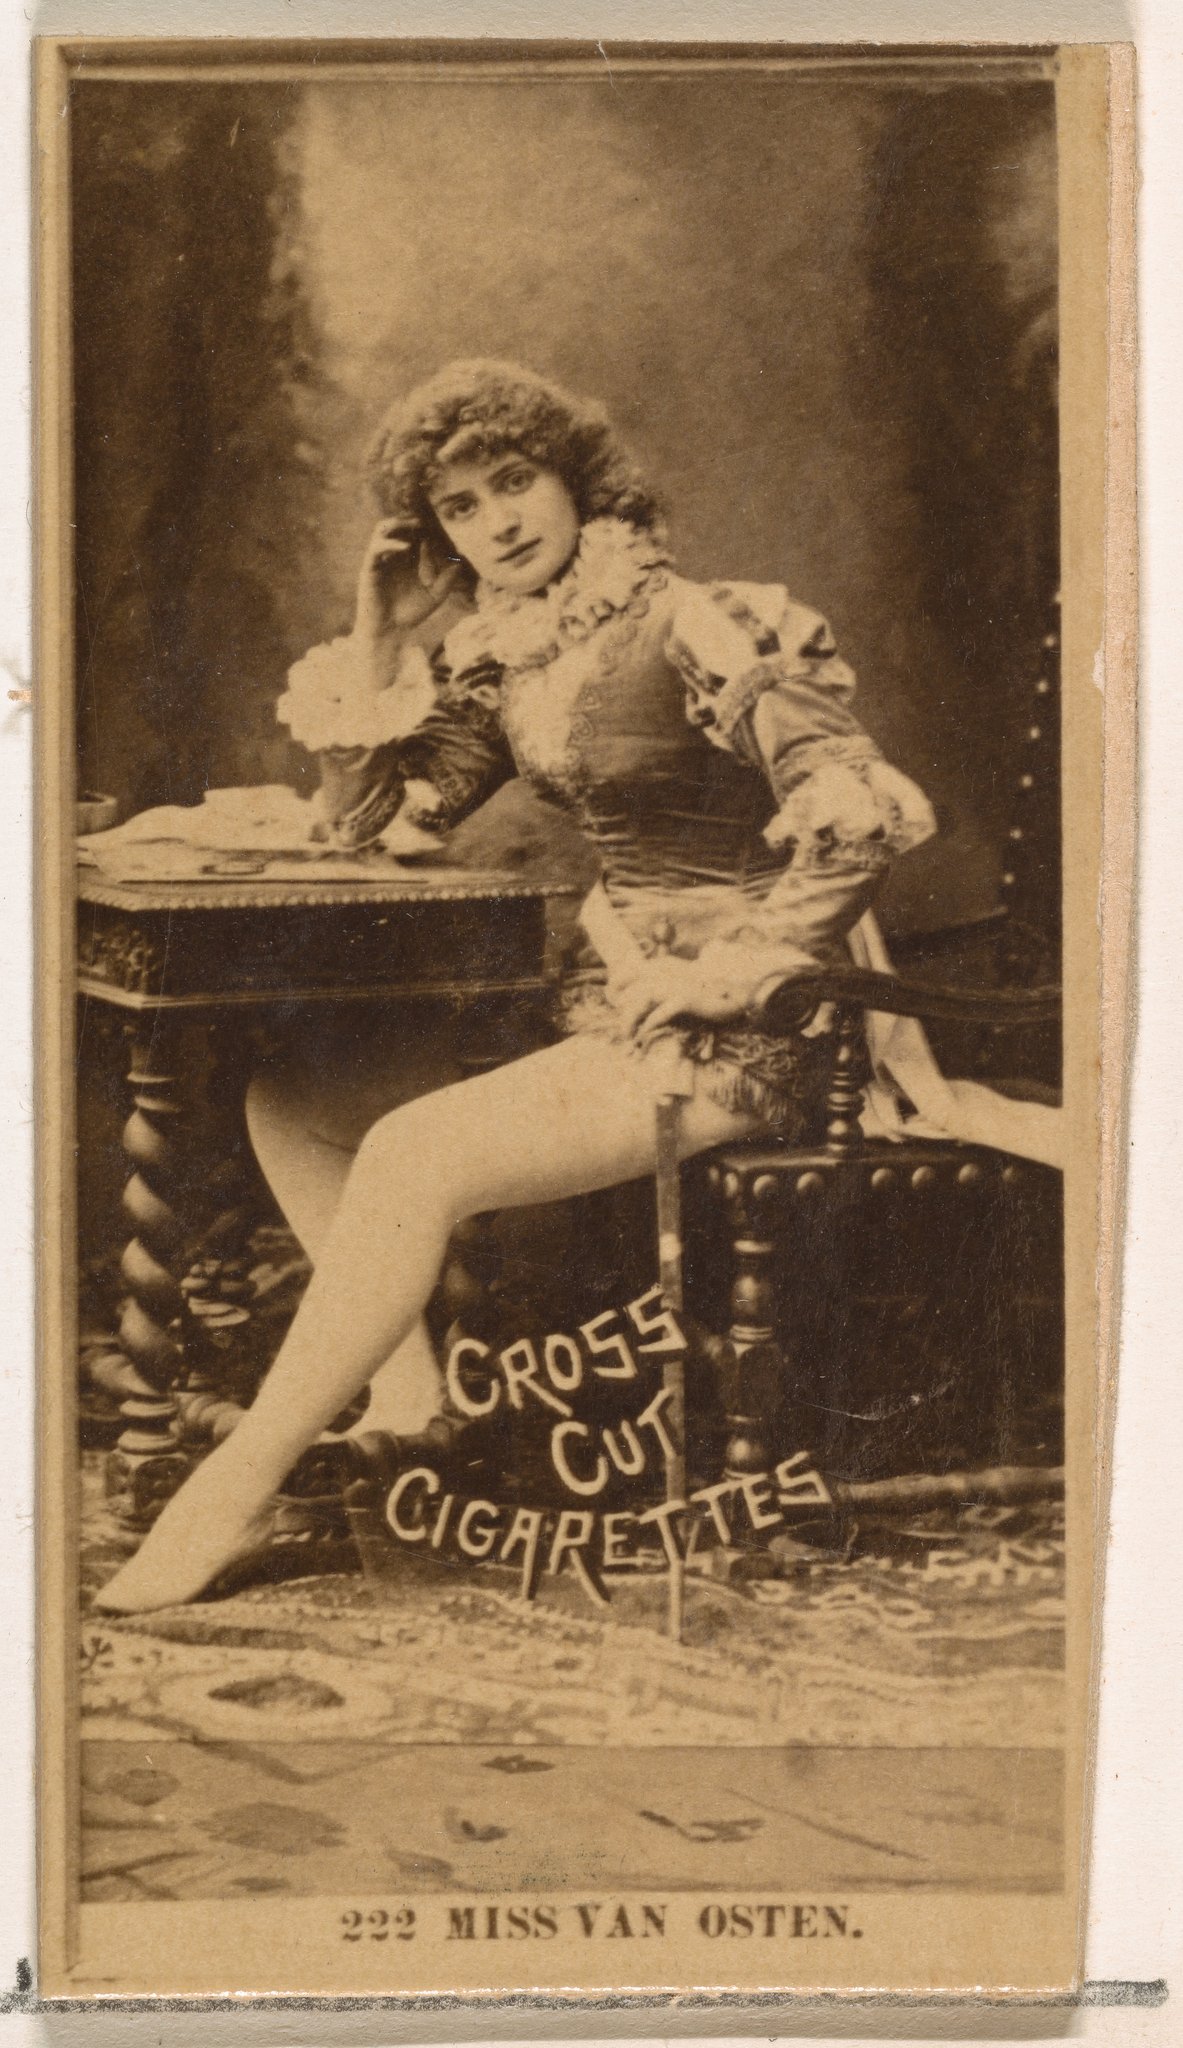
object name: print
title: Card Number 222, Miss Van Osten, from the Actors and Actresses series (N145-2) issued by Duke Sons & Co. to promote Cross Cut Cigarettes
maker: w. duke, sons & co.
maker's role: publisher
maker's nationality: american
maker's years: 1870-1920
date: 1880-1889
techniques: albumen silver print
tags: portraits,women,actresses